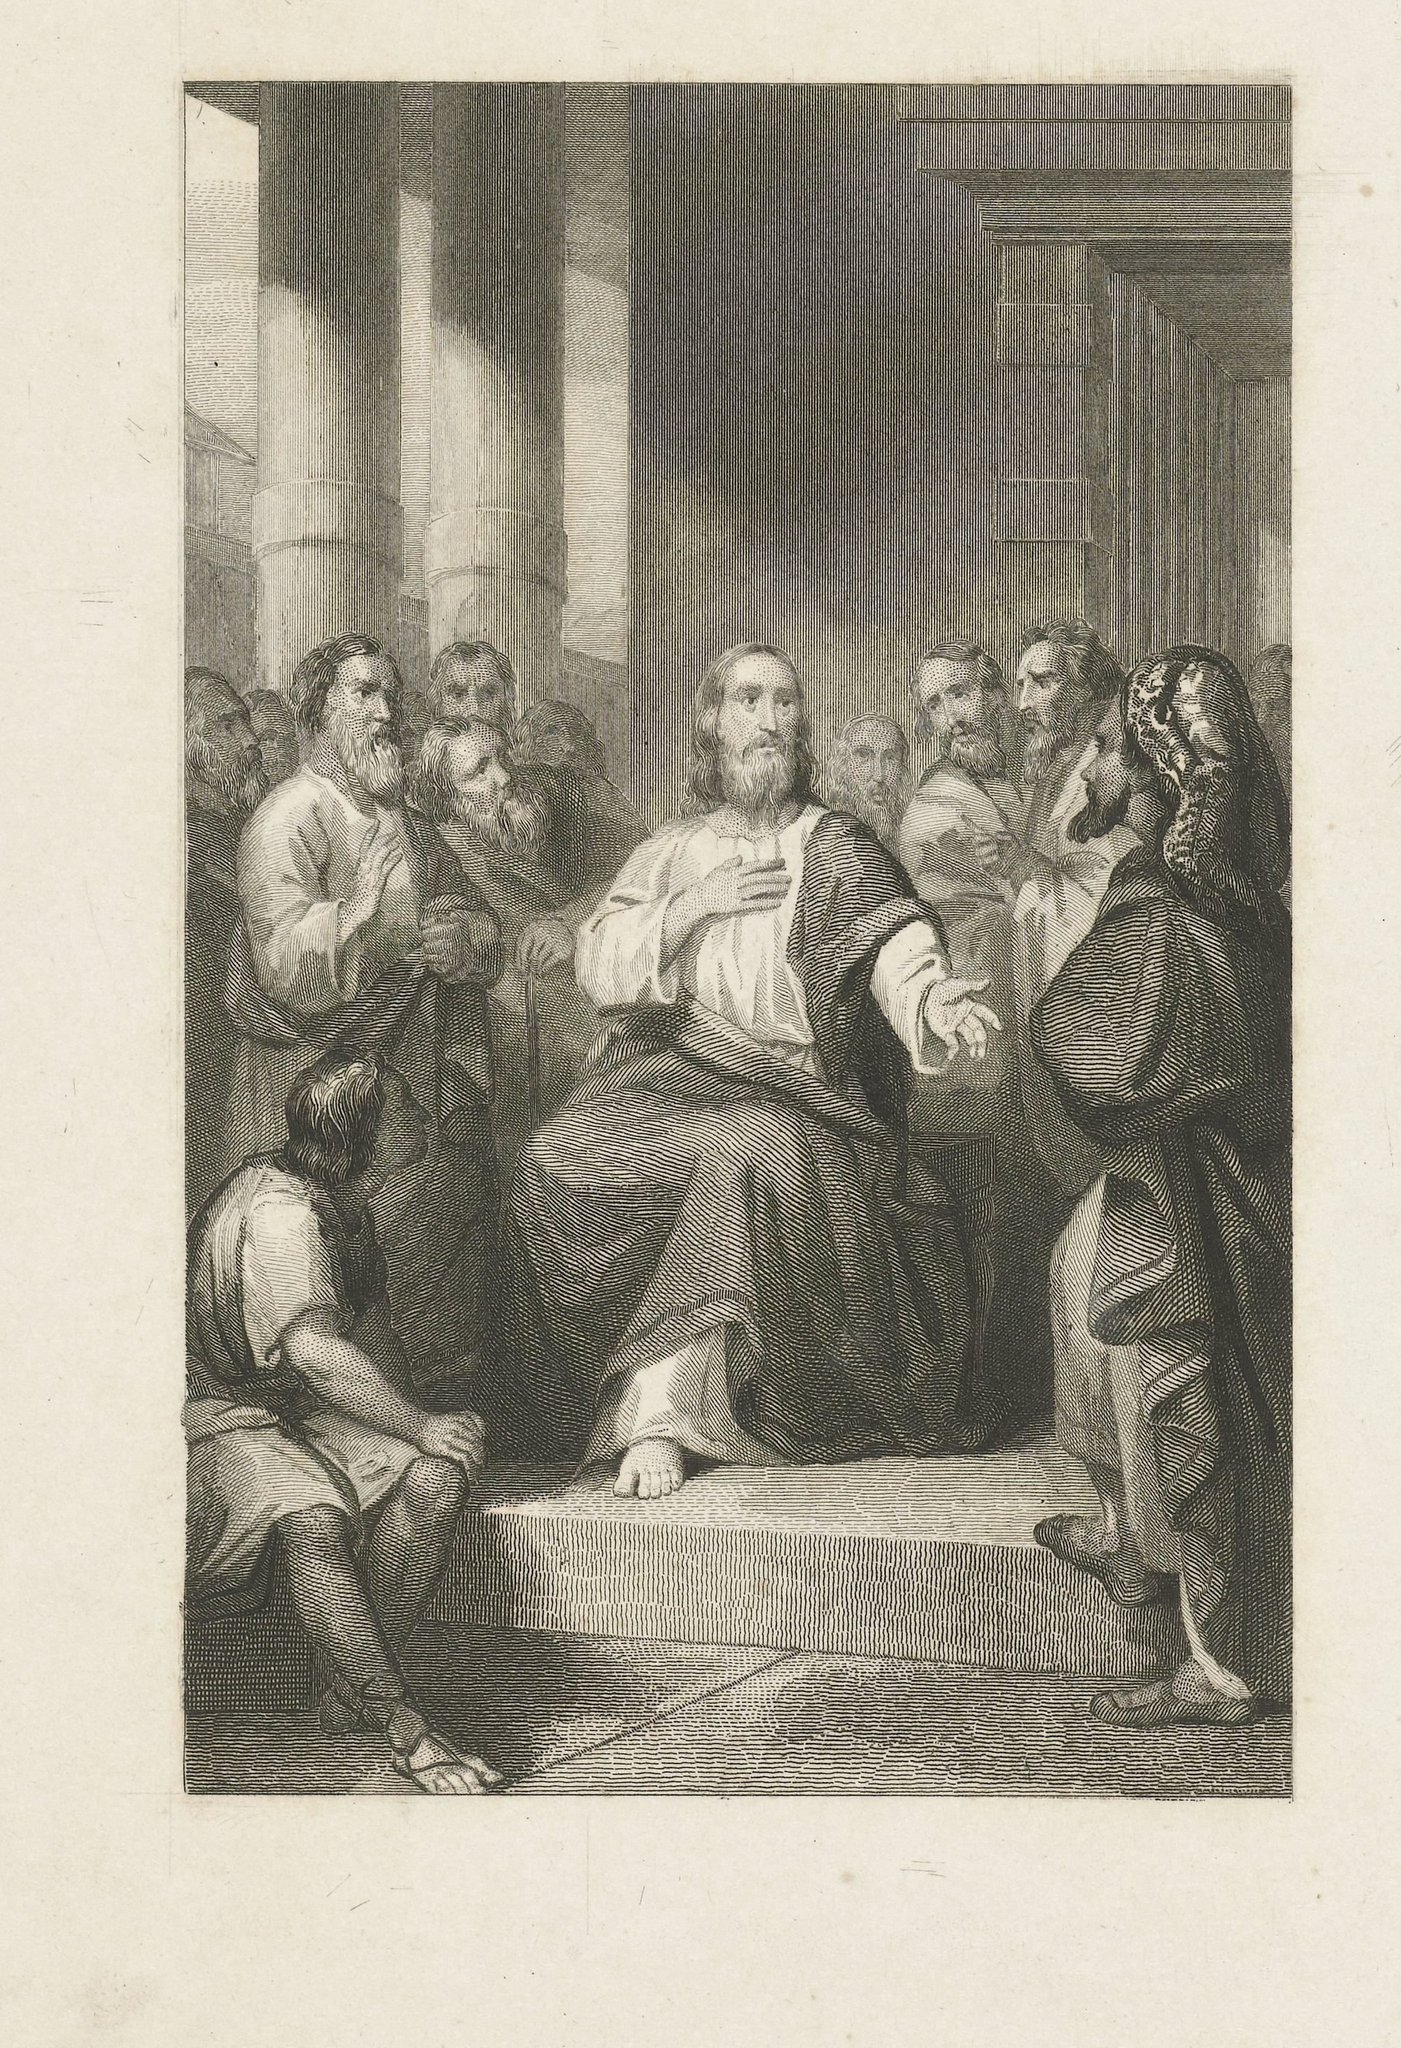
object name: book illustration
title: Christus disputeert met mannen in de tempel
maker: henricus wilhelmus couwenberg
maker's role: draughtsman, print maker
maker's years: 1814-1845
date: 1830-1840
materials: paper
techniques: engraving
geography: amsterdam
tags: christ explaining his doctrine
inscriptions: collector's mark: Lugt 2228